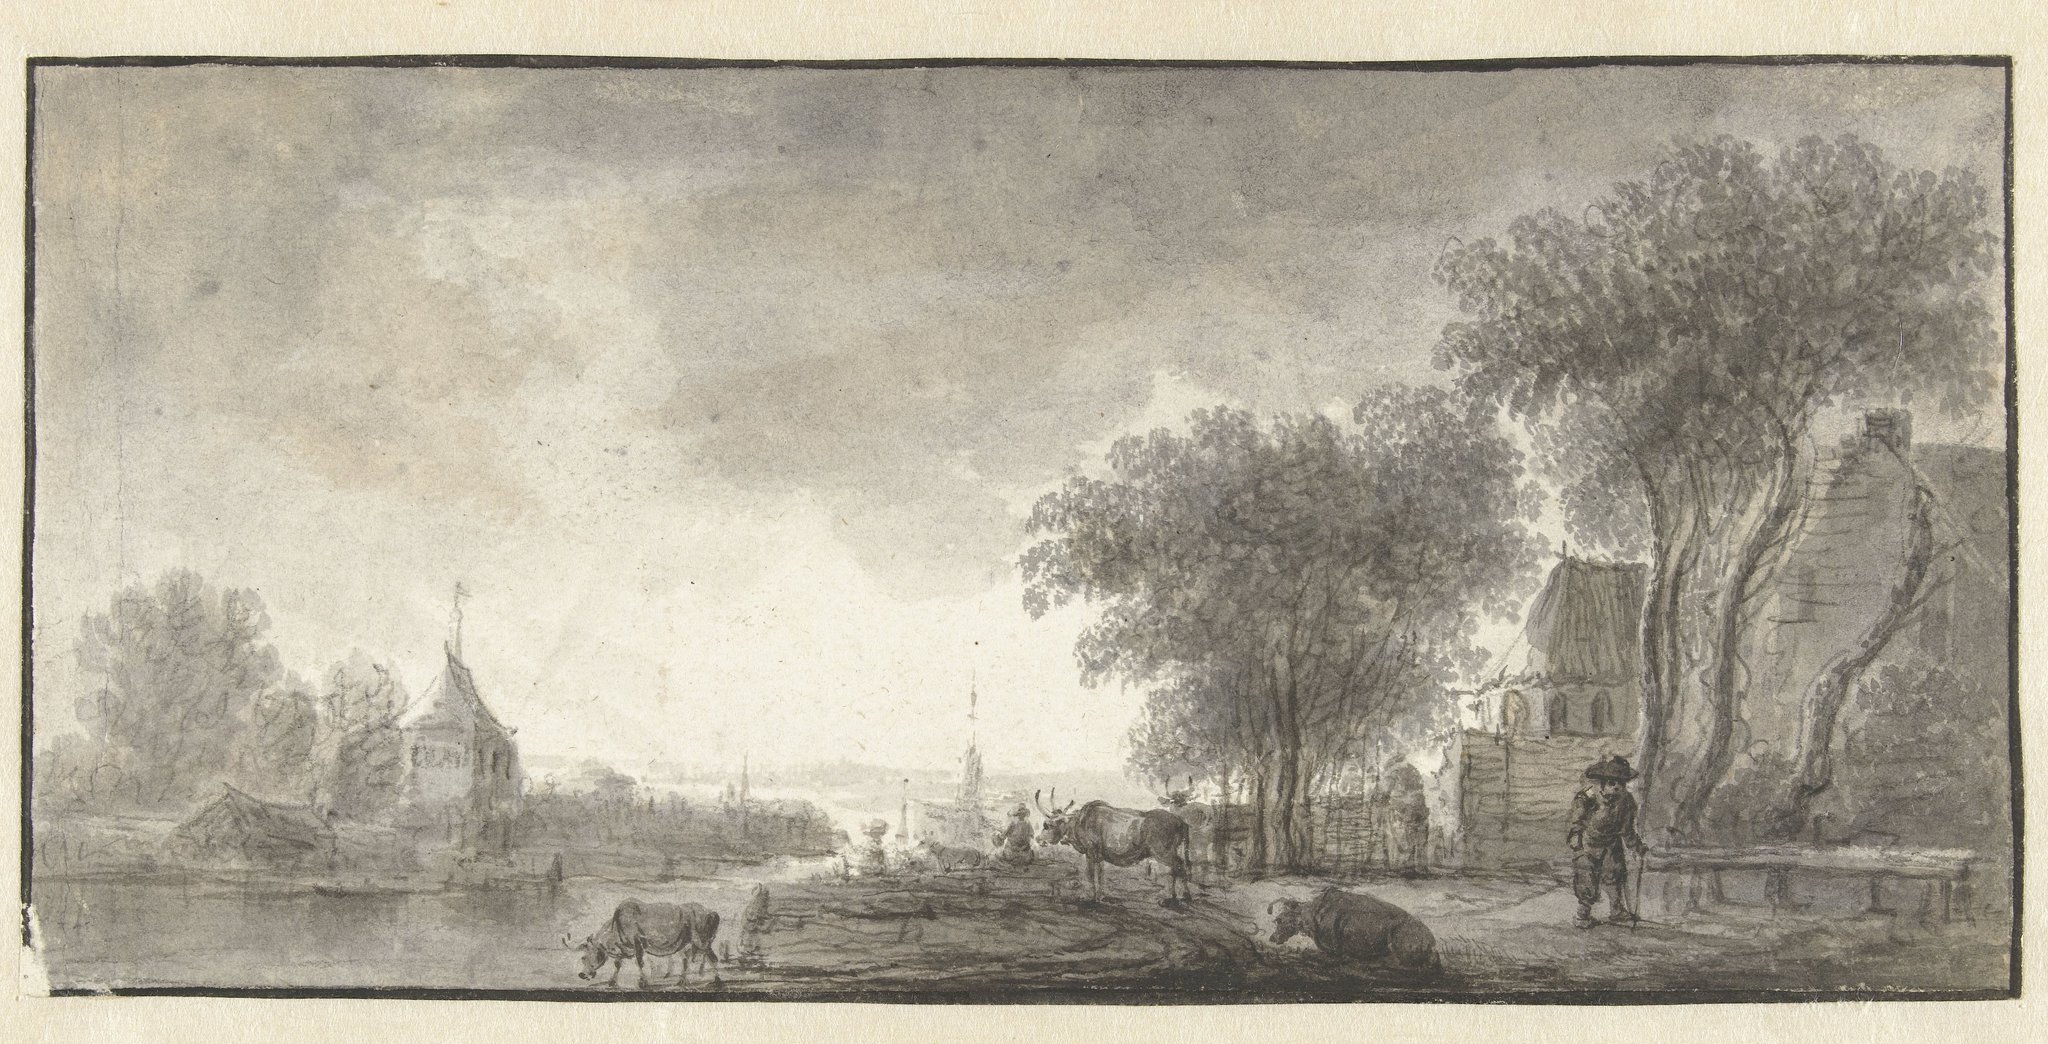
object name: drawing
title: Rivierlandschap met vee en enkele huizen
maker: Anonymous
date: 1600-1699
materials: ink, paper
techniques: brush, pen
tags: river, farm or solitary house in landscape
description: Rivierlandschap met vee en enige huizen; op de verso enige berekeningen in rood krijt.